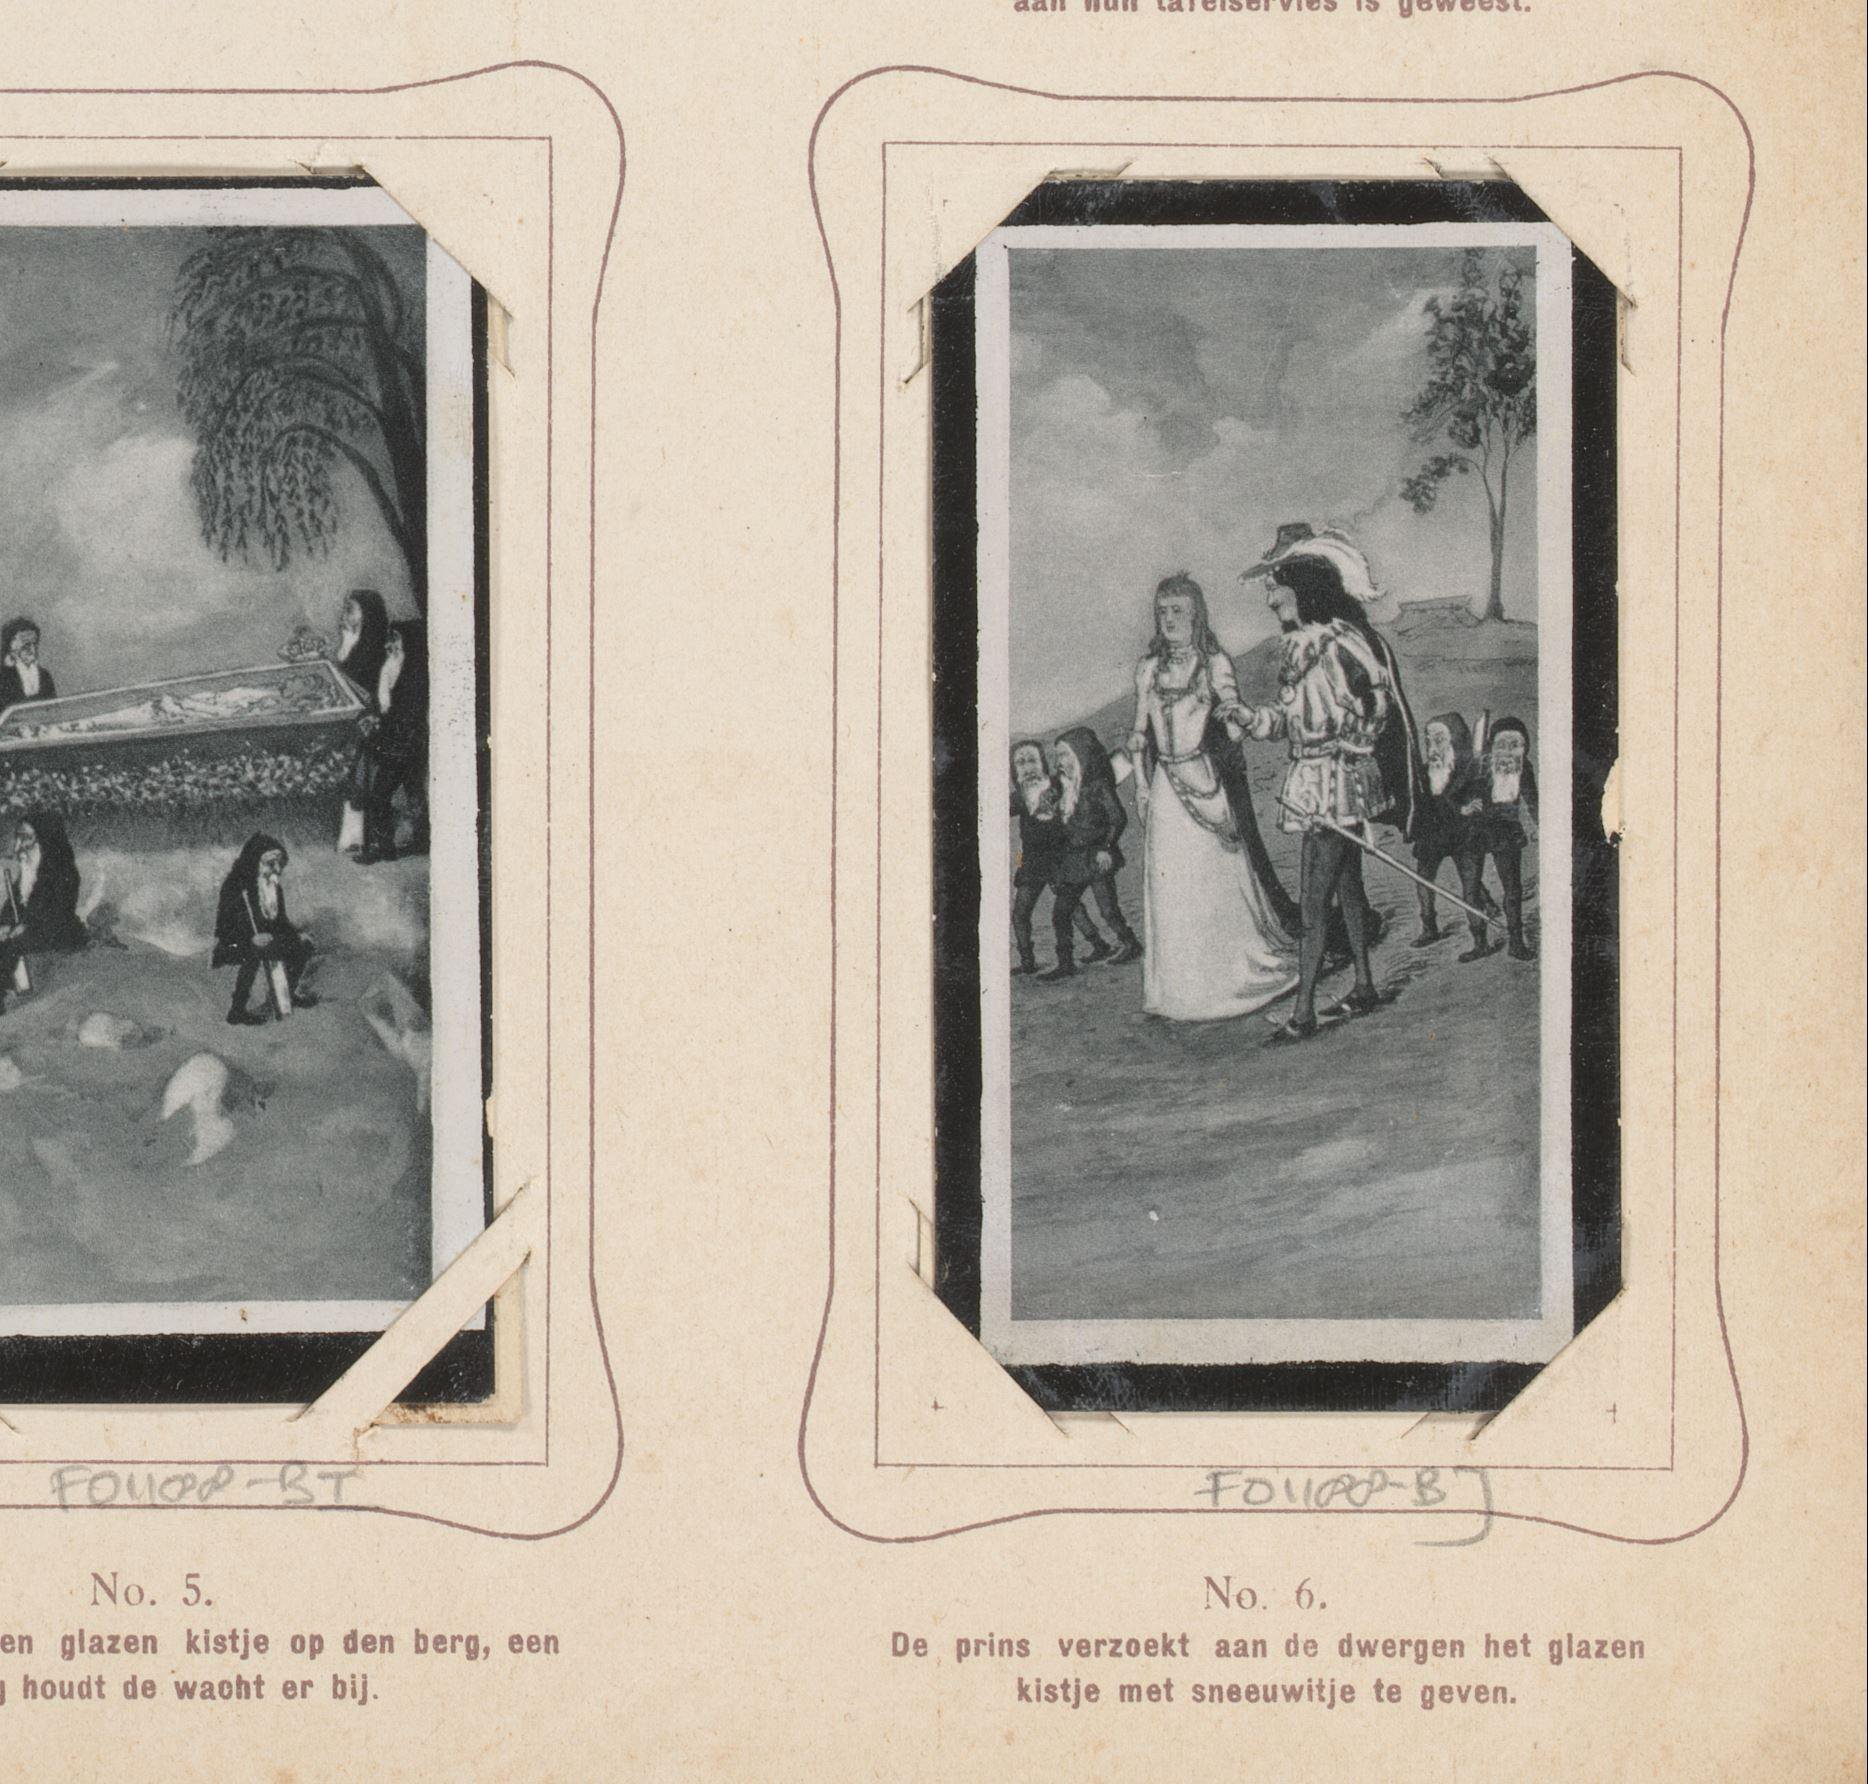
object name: album leaf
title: Sneeuwwitje met de prins en de zeven dwergen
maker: Anonymous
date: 1906-1907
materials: paper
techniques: photograph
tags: tales and fairy tales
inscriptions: inscription: ‘No. 6./ De prins verzoekt aan de dwergen het glazen kistje met sneeuwitje te geven.’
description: Deze prent maakt deel uit van een album.